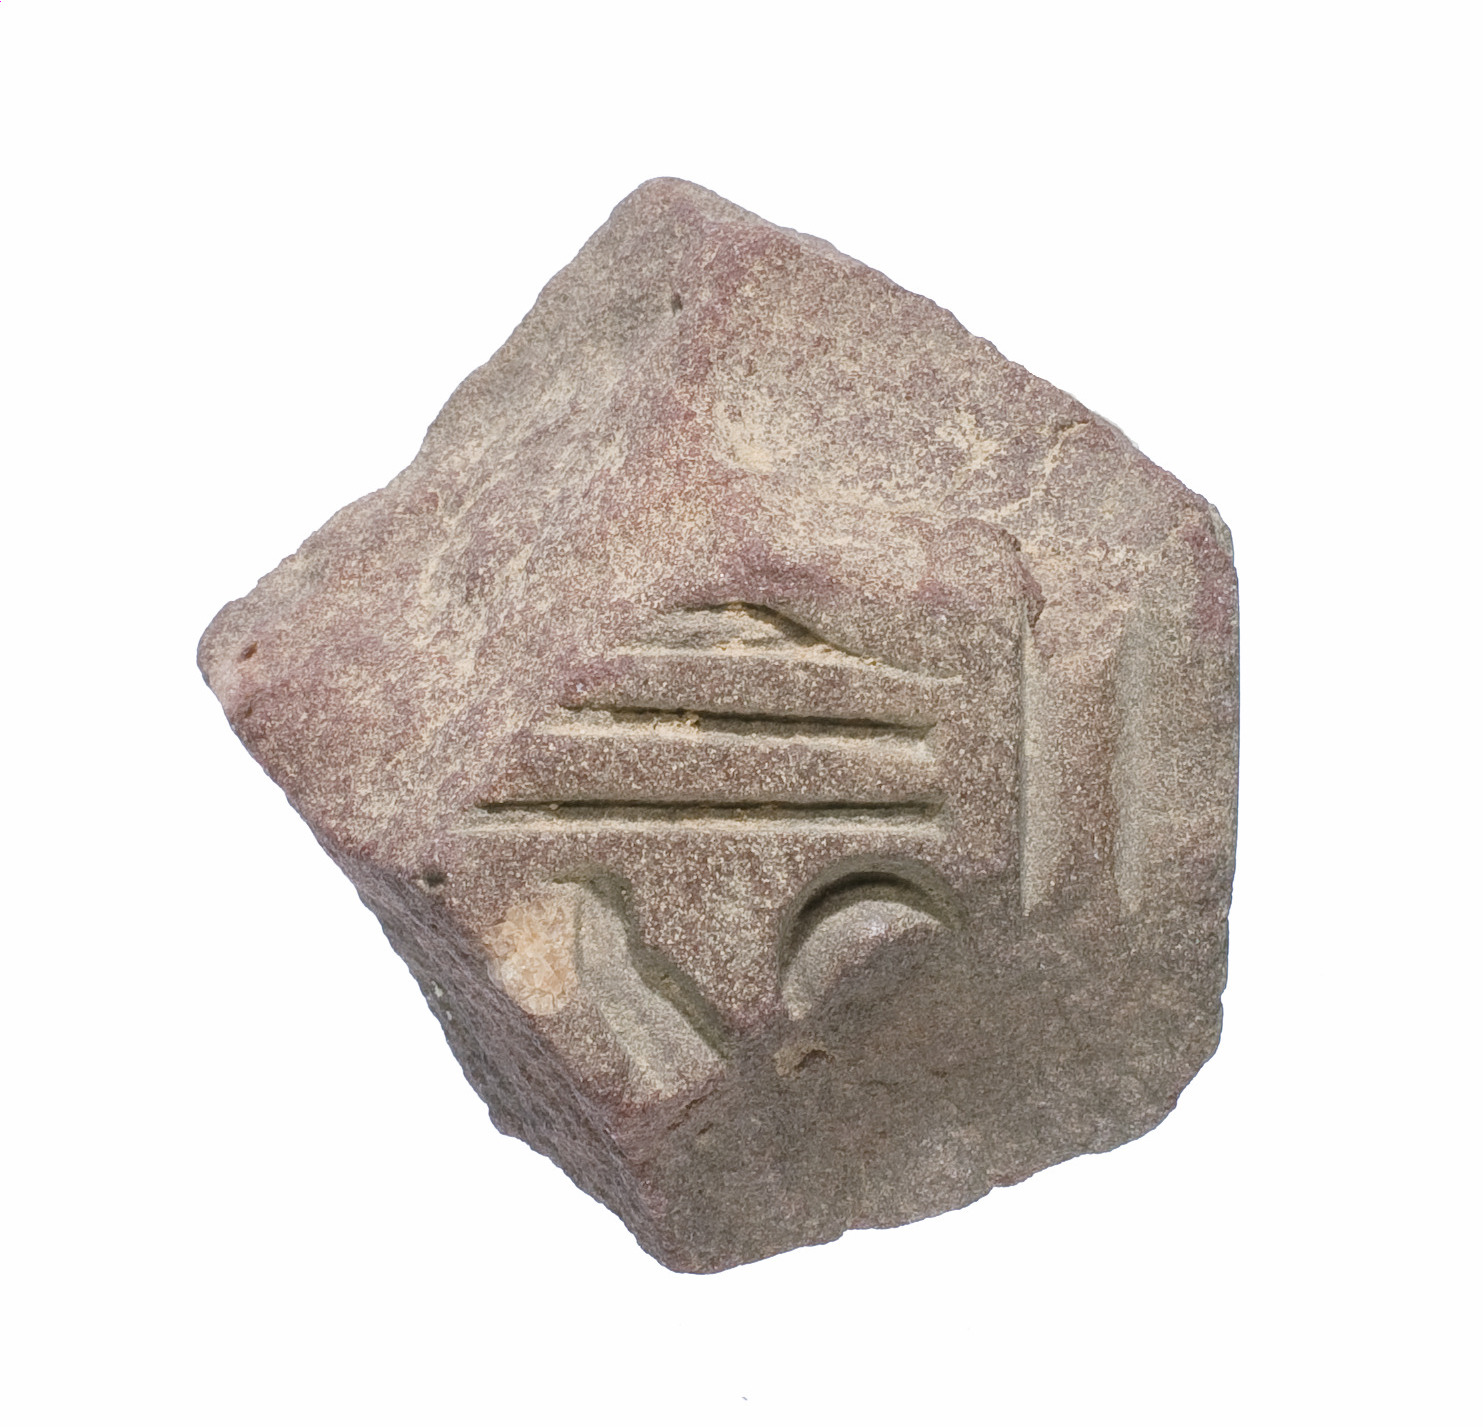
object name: small block, name of akhenaten, nefertiti, aten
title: Part of a small block with parts of names of the Aten and Akhenaten preserved on two adjacent sides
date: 1353-1336 BCE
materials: quartzite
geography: egypt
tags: hieroglyphs